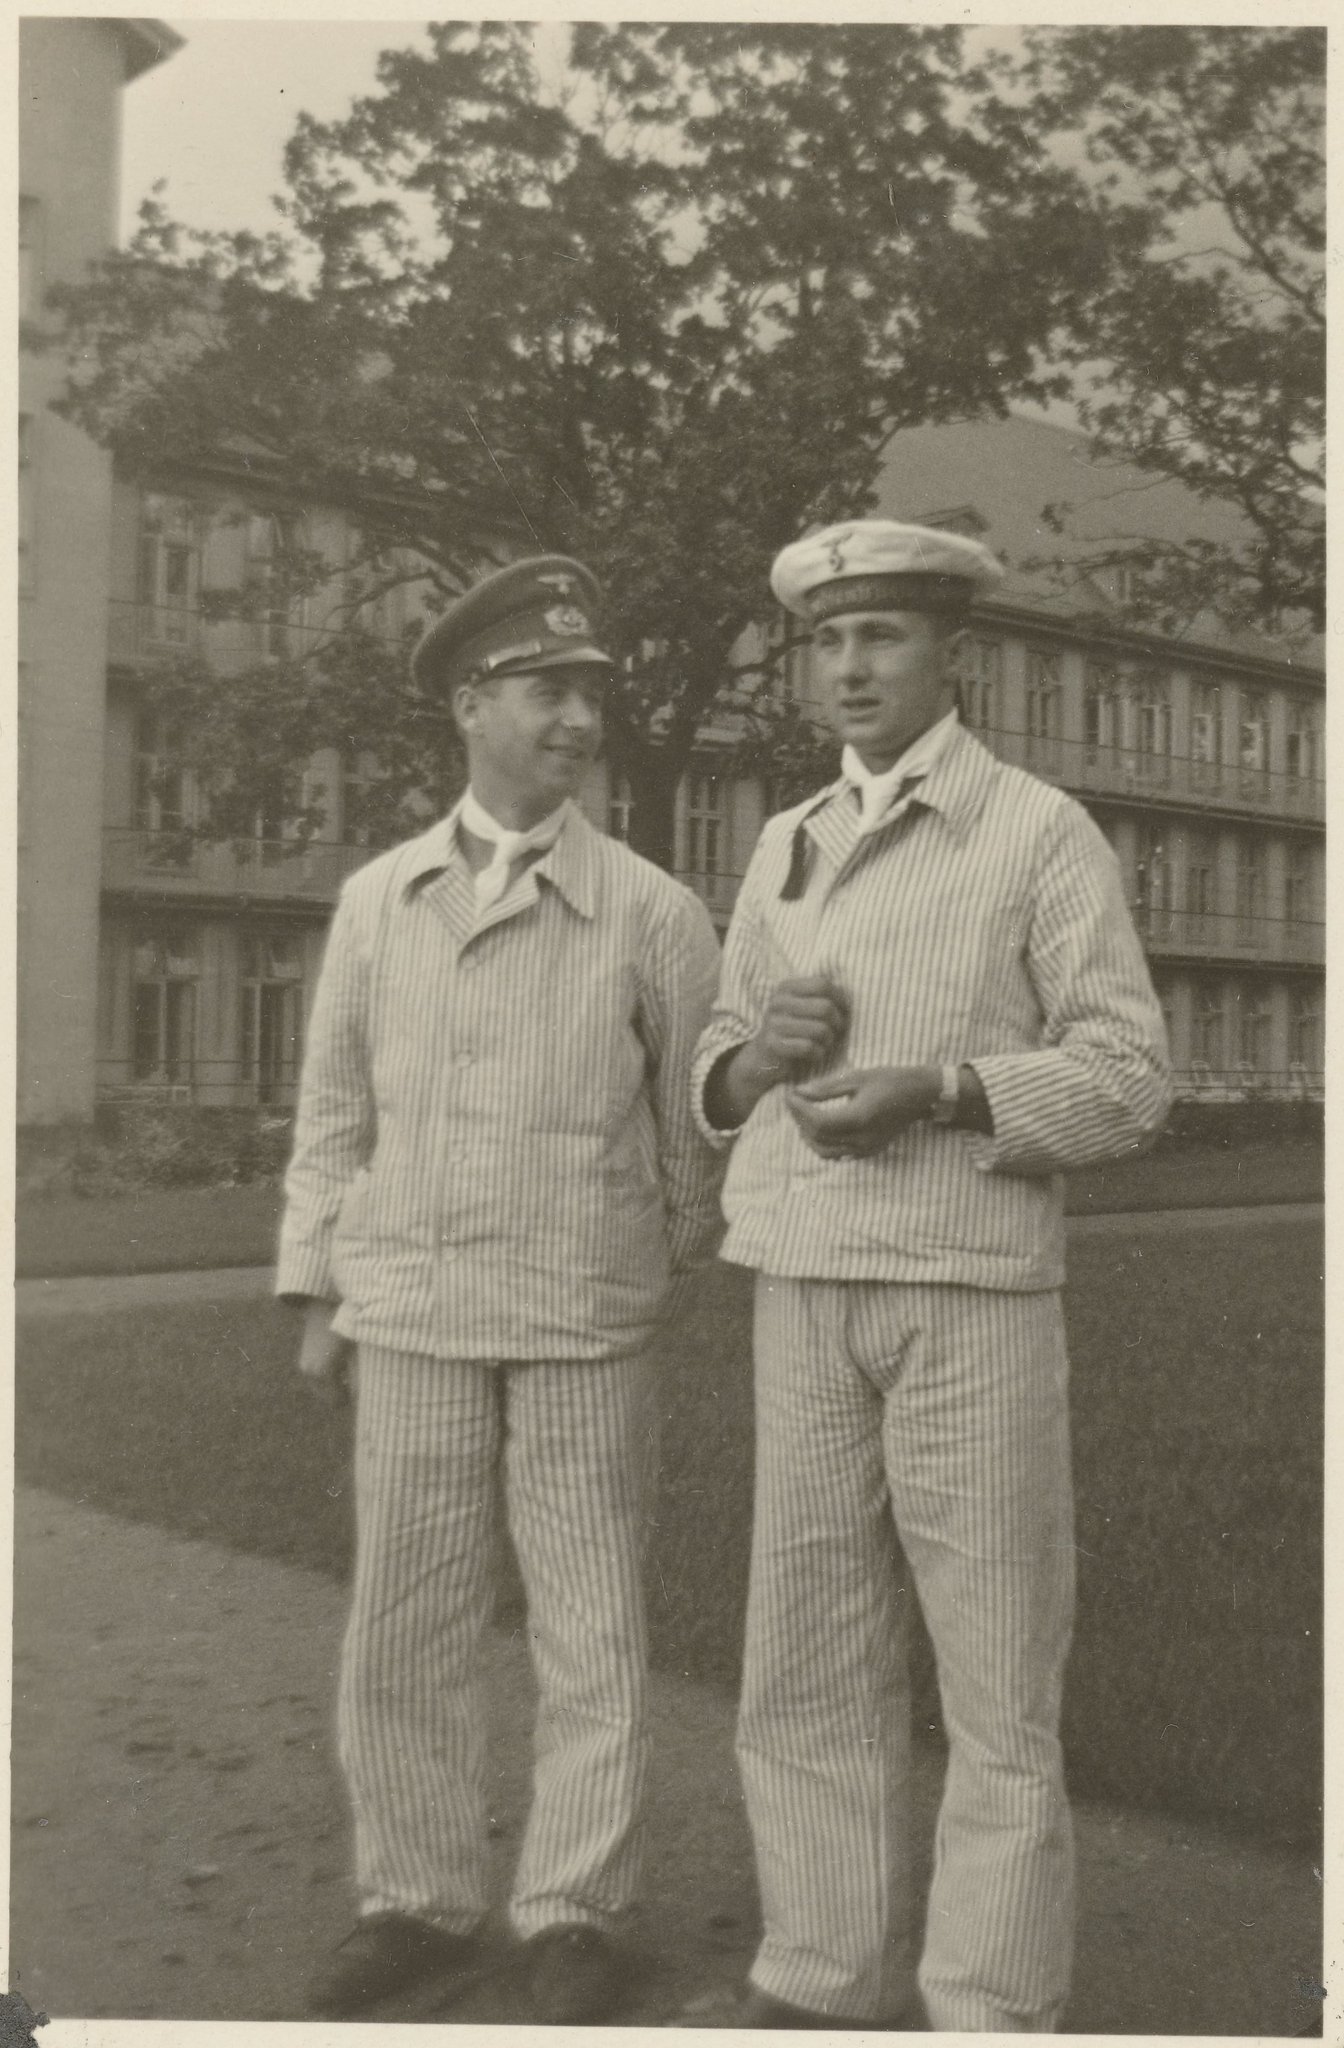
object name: photograph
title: Foto behorend bij album Kriegserinnerungen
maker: Anonymous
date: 1940-1945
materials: photographic support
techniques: gelatin silver print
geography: netherlands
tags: netherlands, germany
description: Foto behorend bij album 'Kriegserinnerungen'.